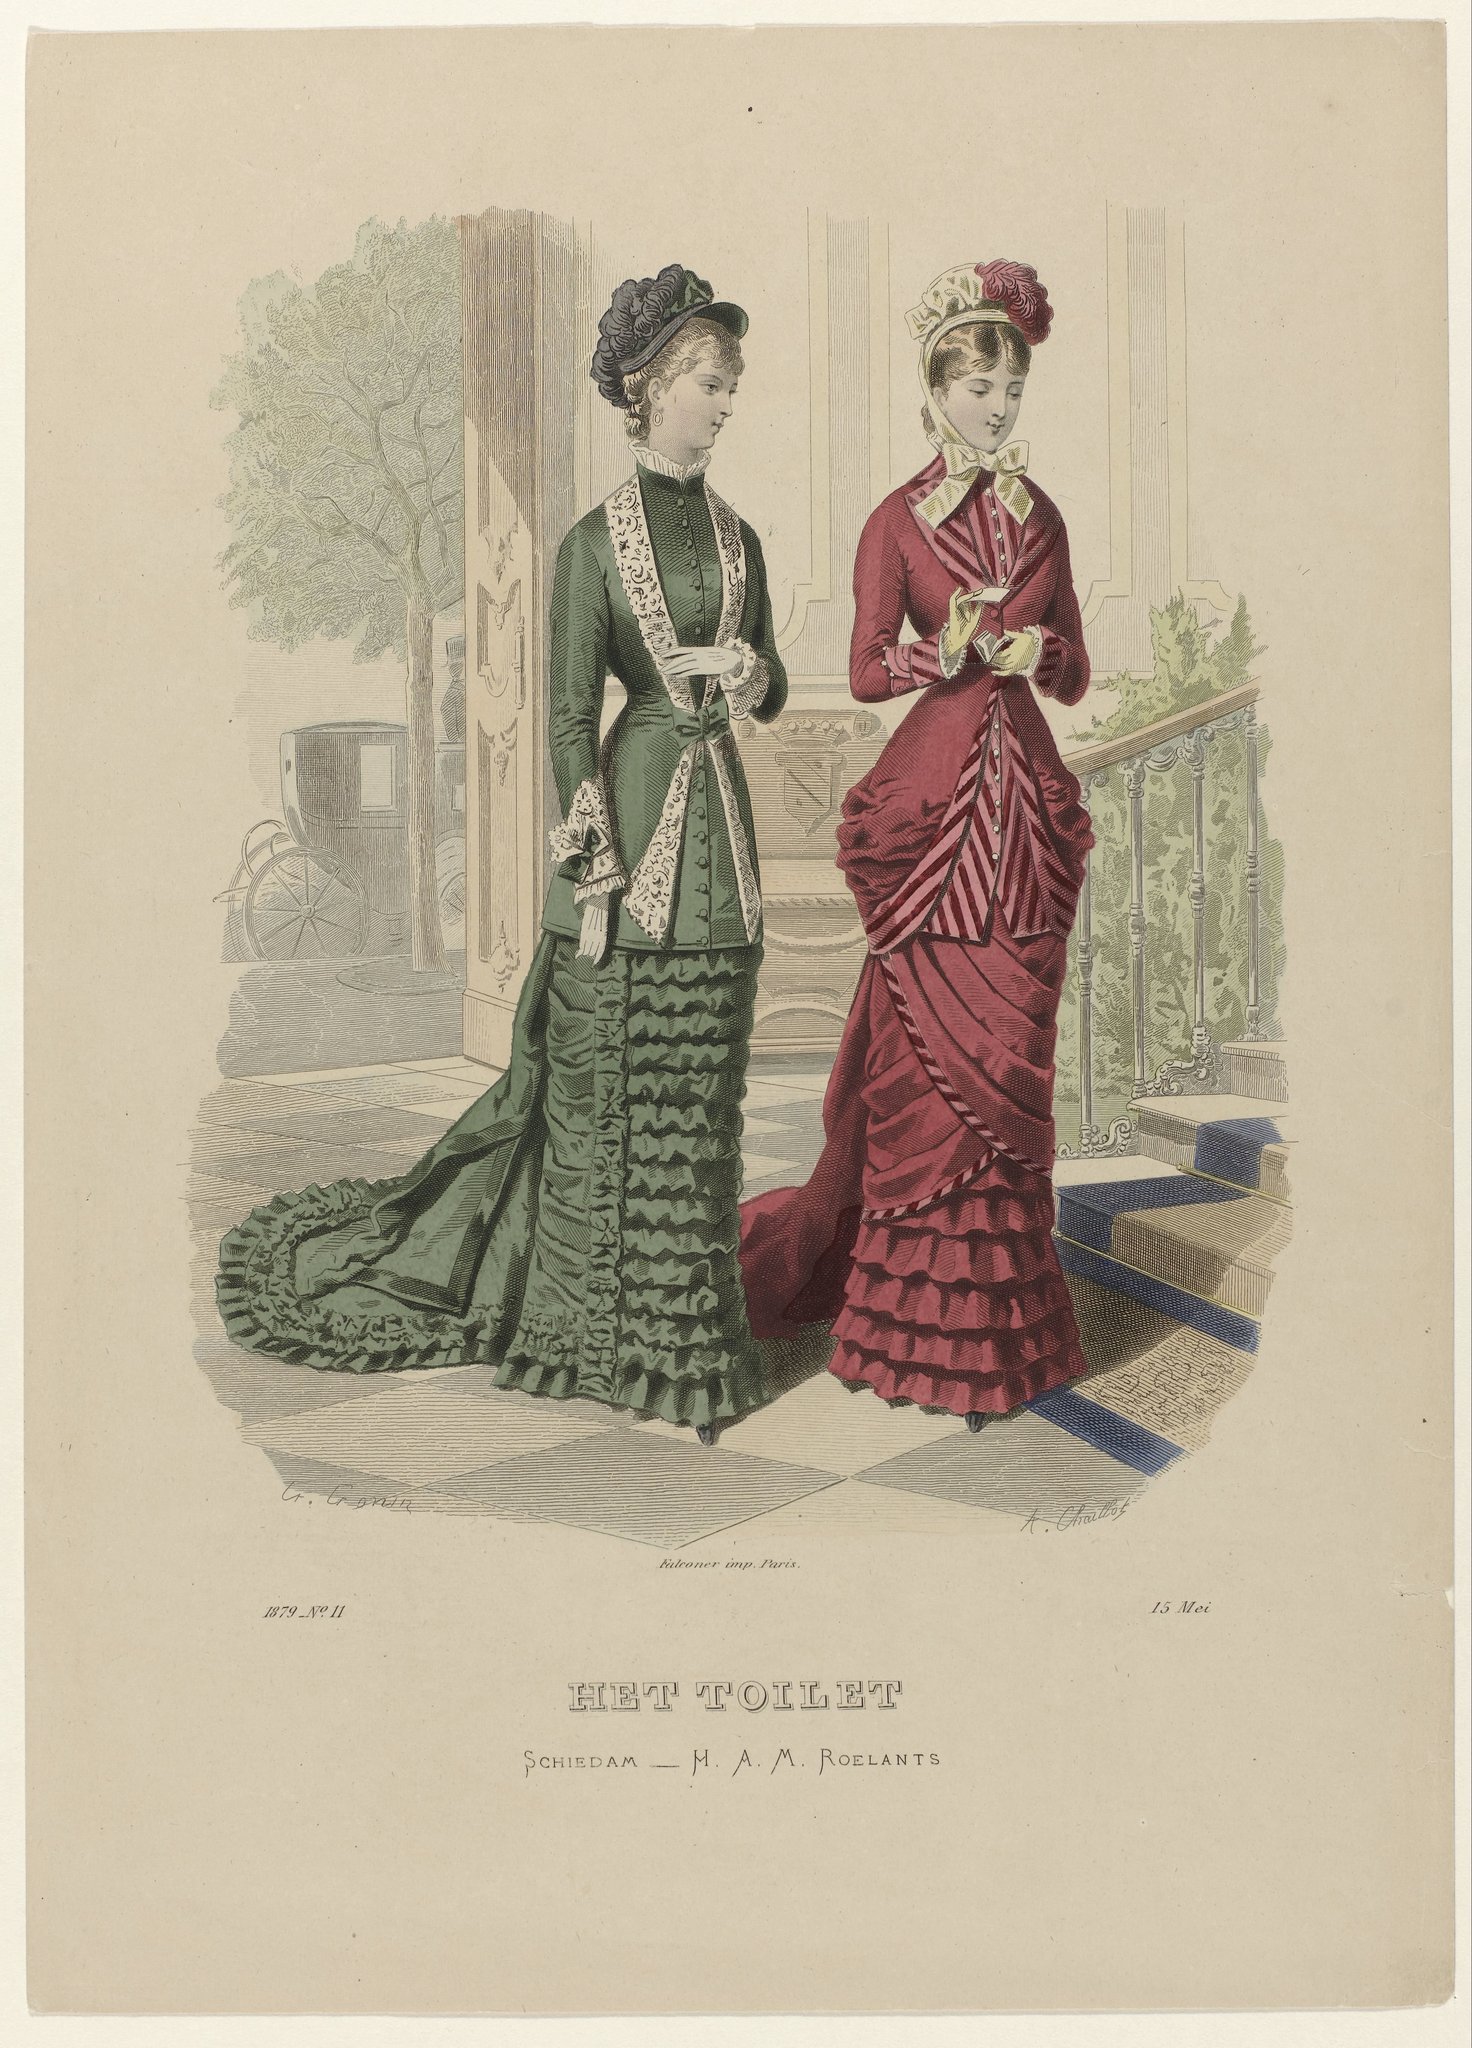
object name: fashion print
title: Het Toilet, 15 mei 1879, No. 11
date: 1879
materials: paper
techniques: engraving, hand coloring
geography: schiedam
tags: fashion plates, dress, gown (+ women's clothes)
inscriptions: caption: ‘HET TOILET / SCHIEDAM - H.A.M. ROELANTS’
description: Prent uit het modetijdschrift Het Toilet (1877-?).